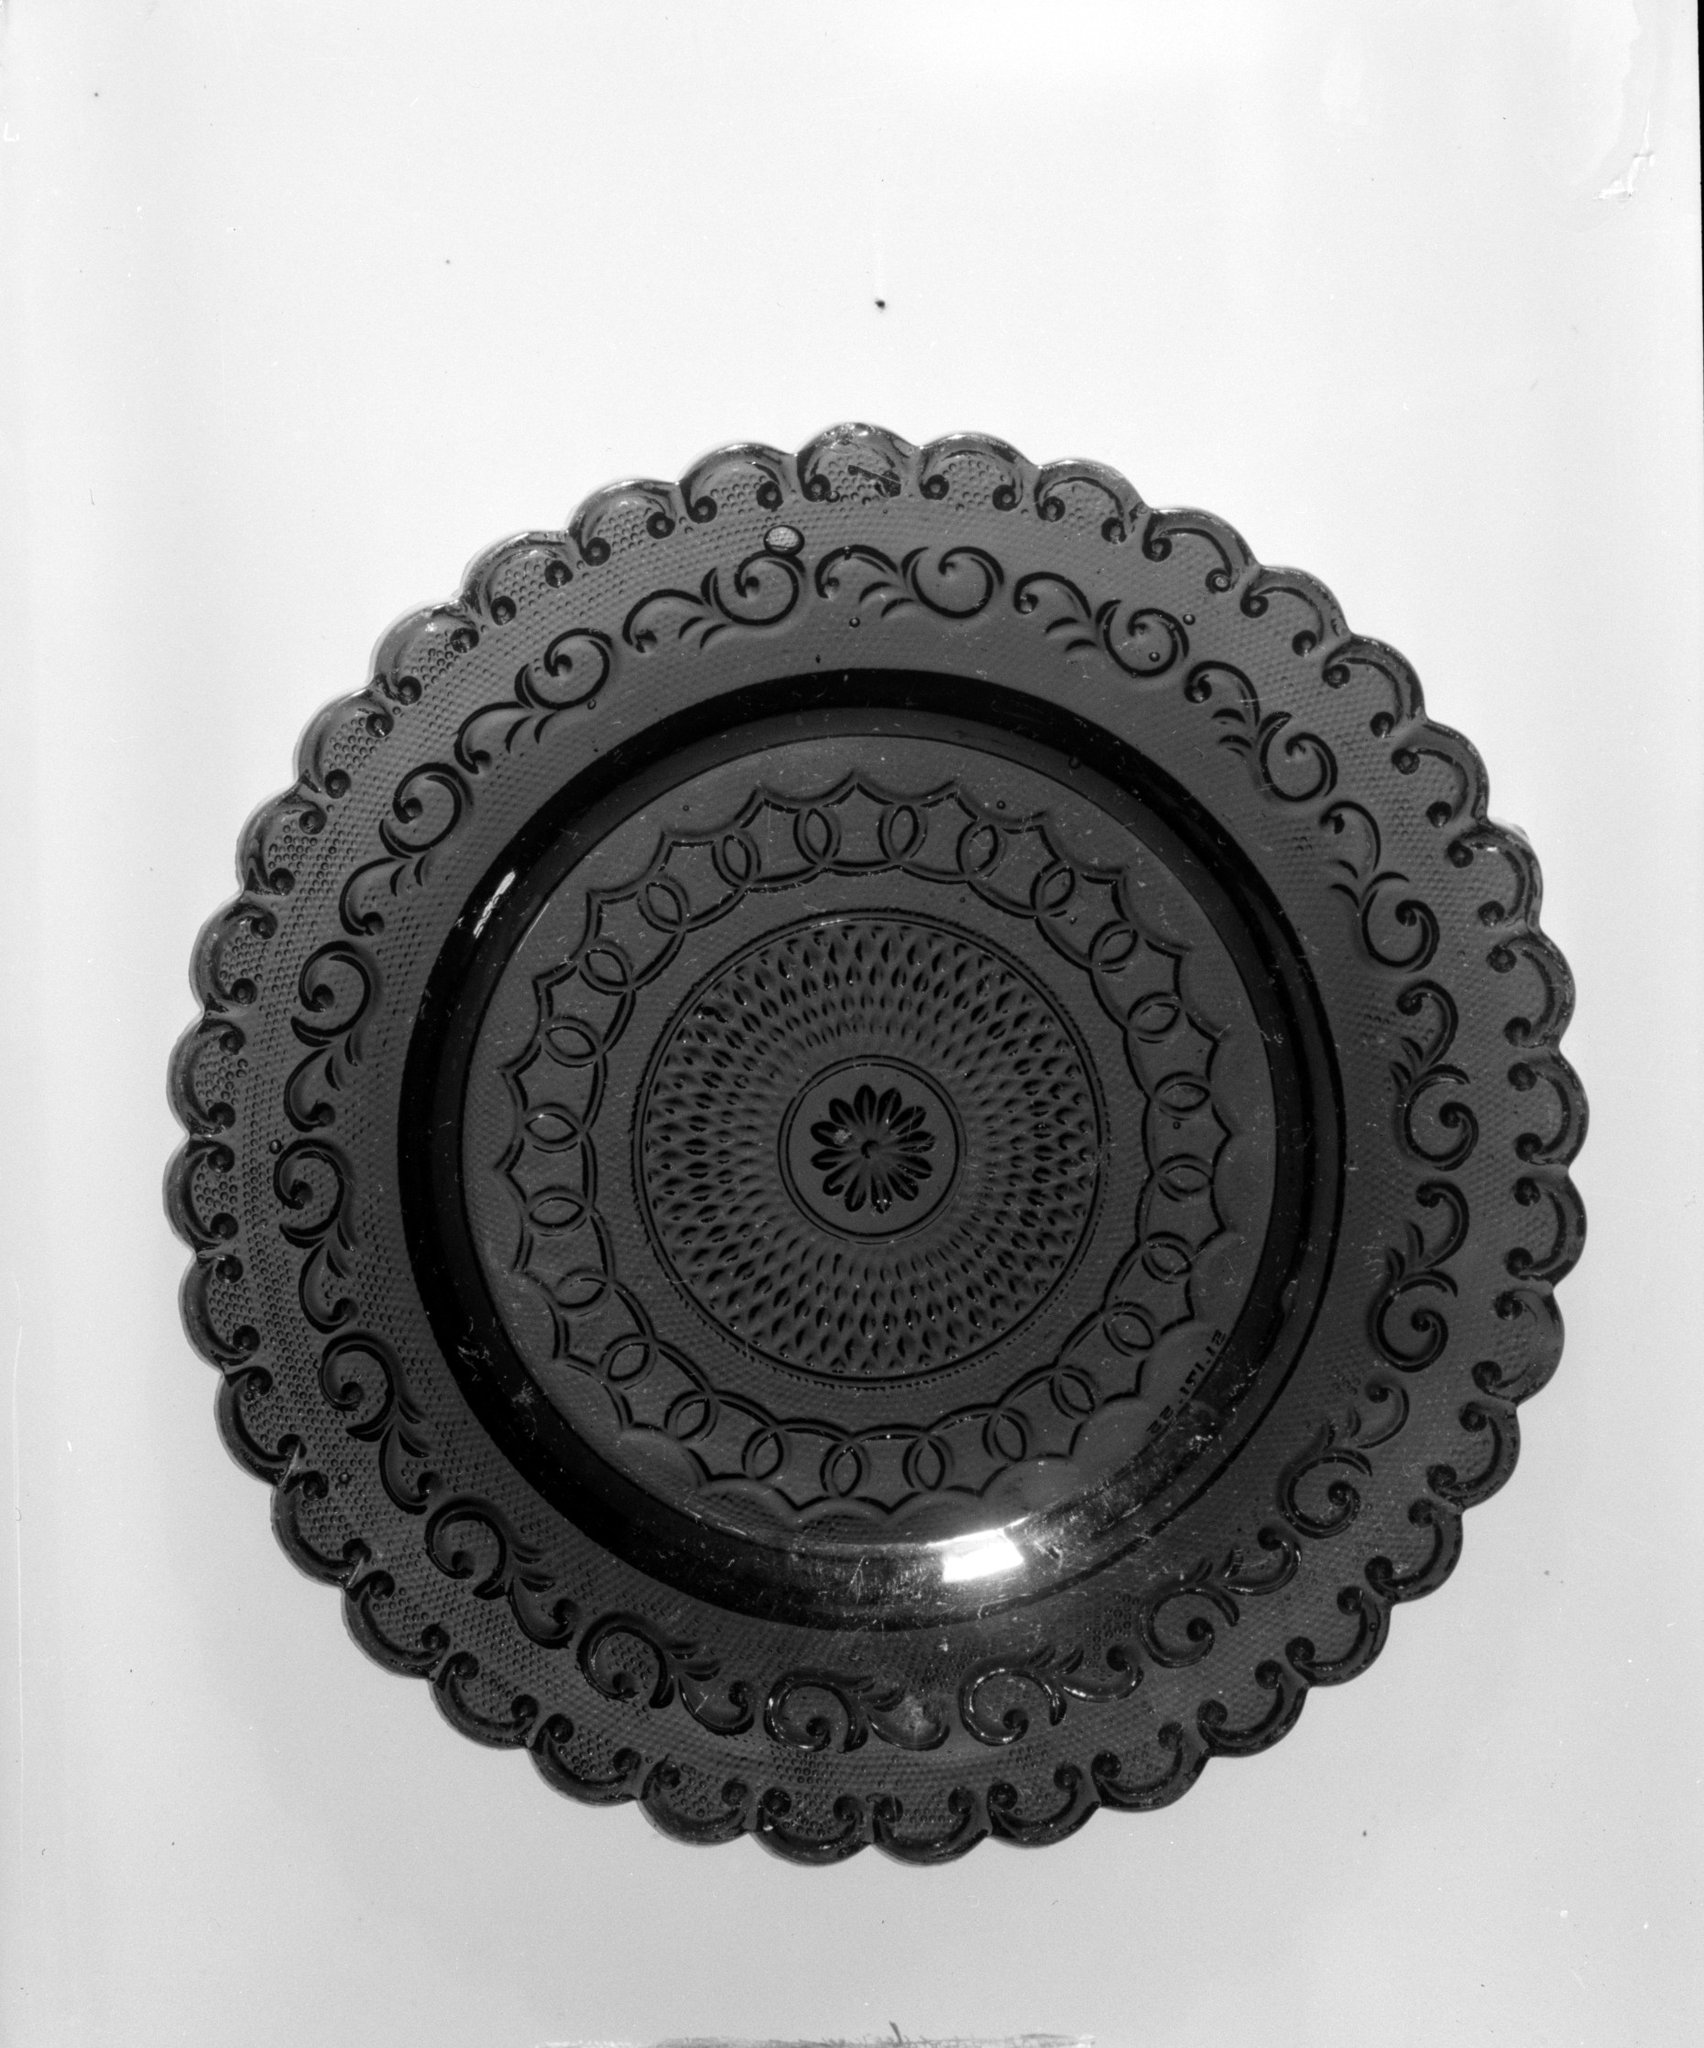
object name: plate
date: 1830-1900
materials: glass